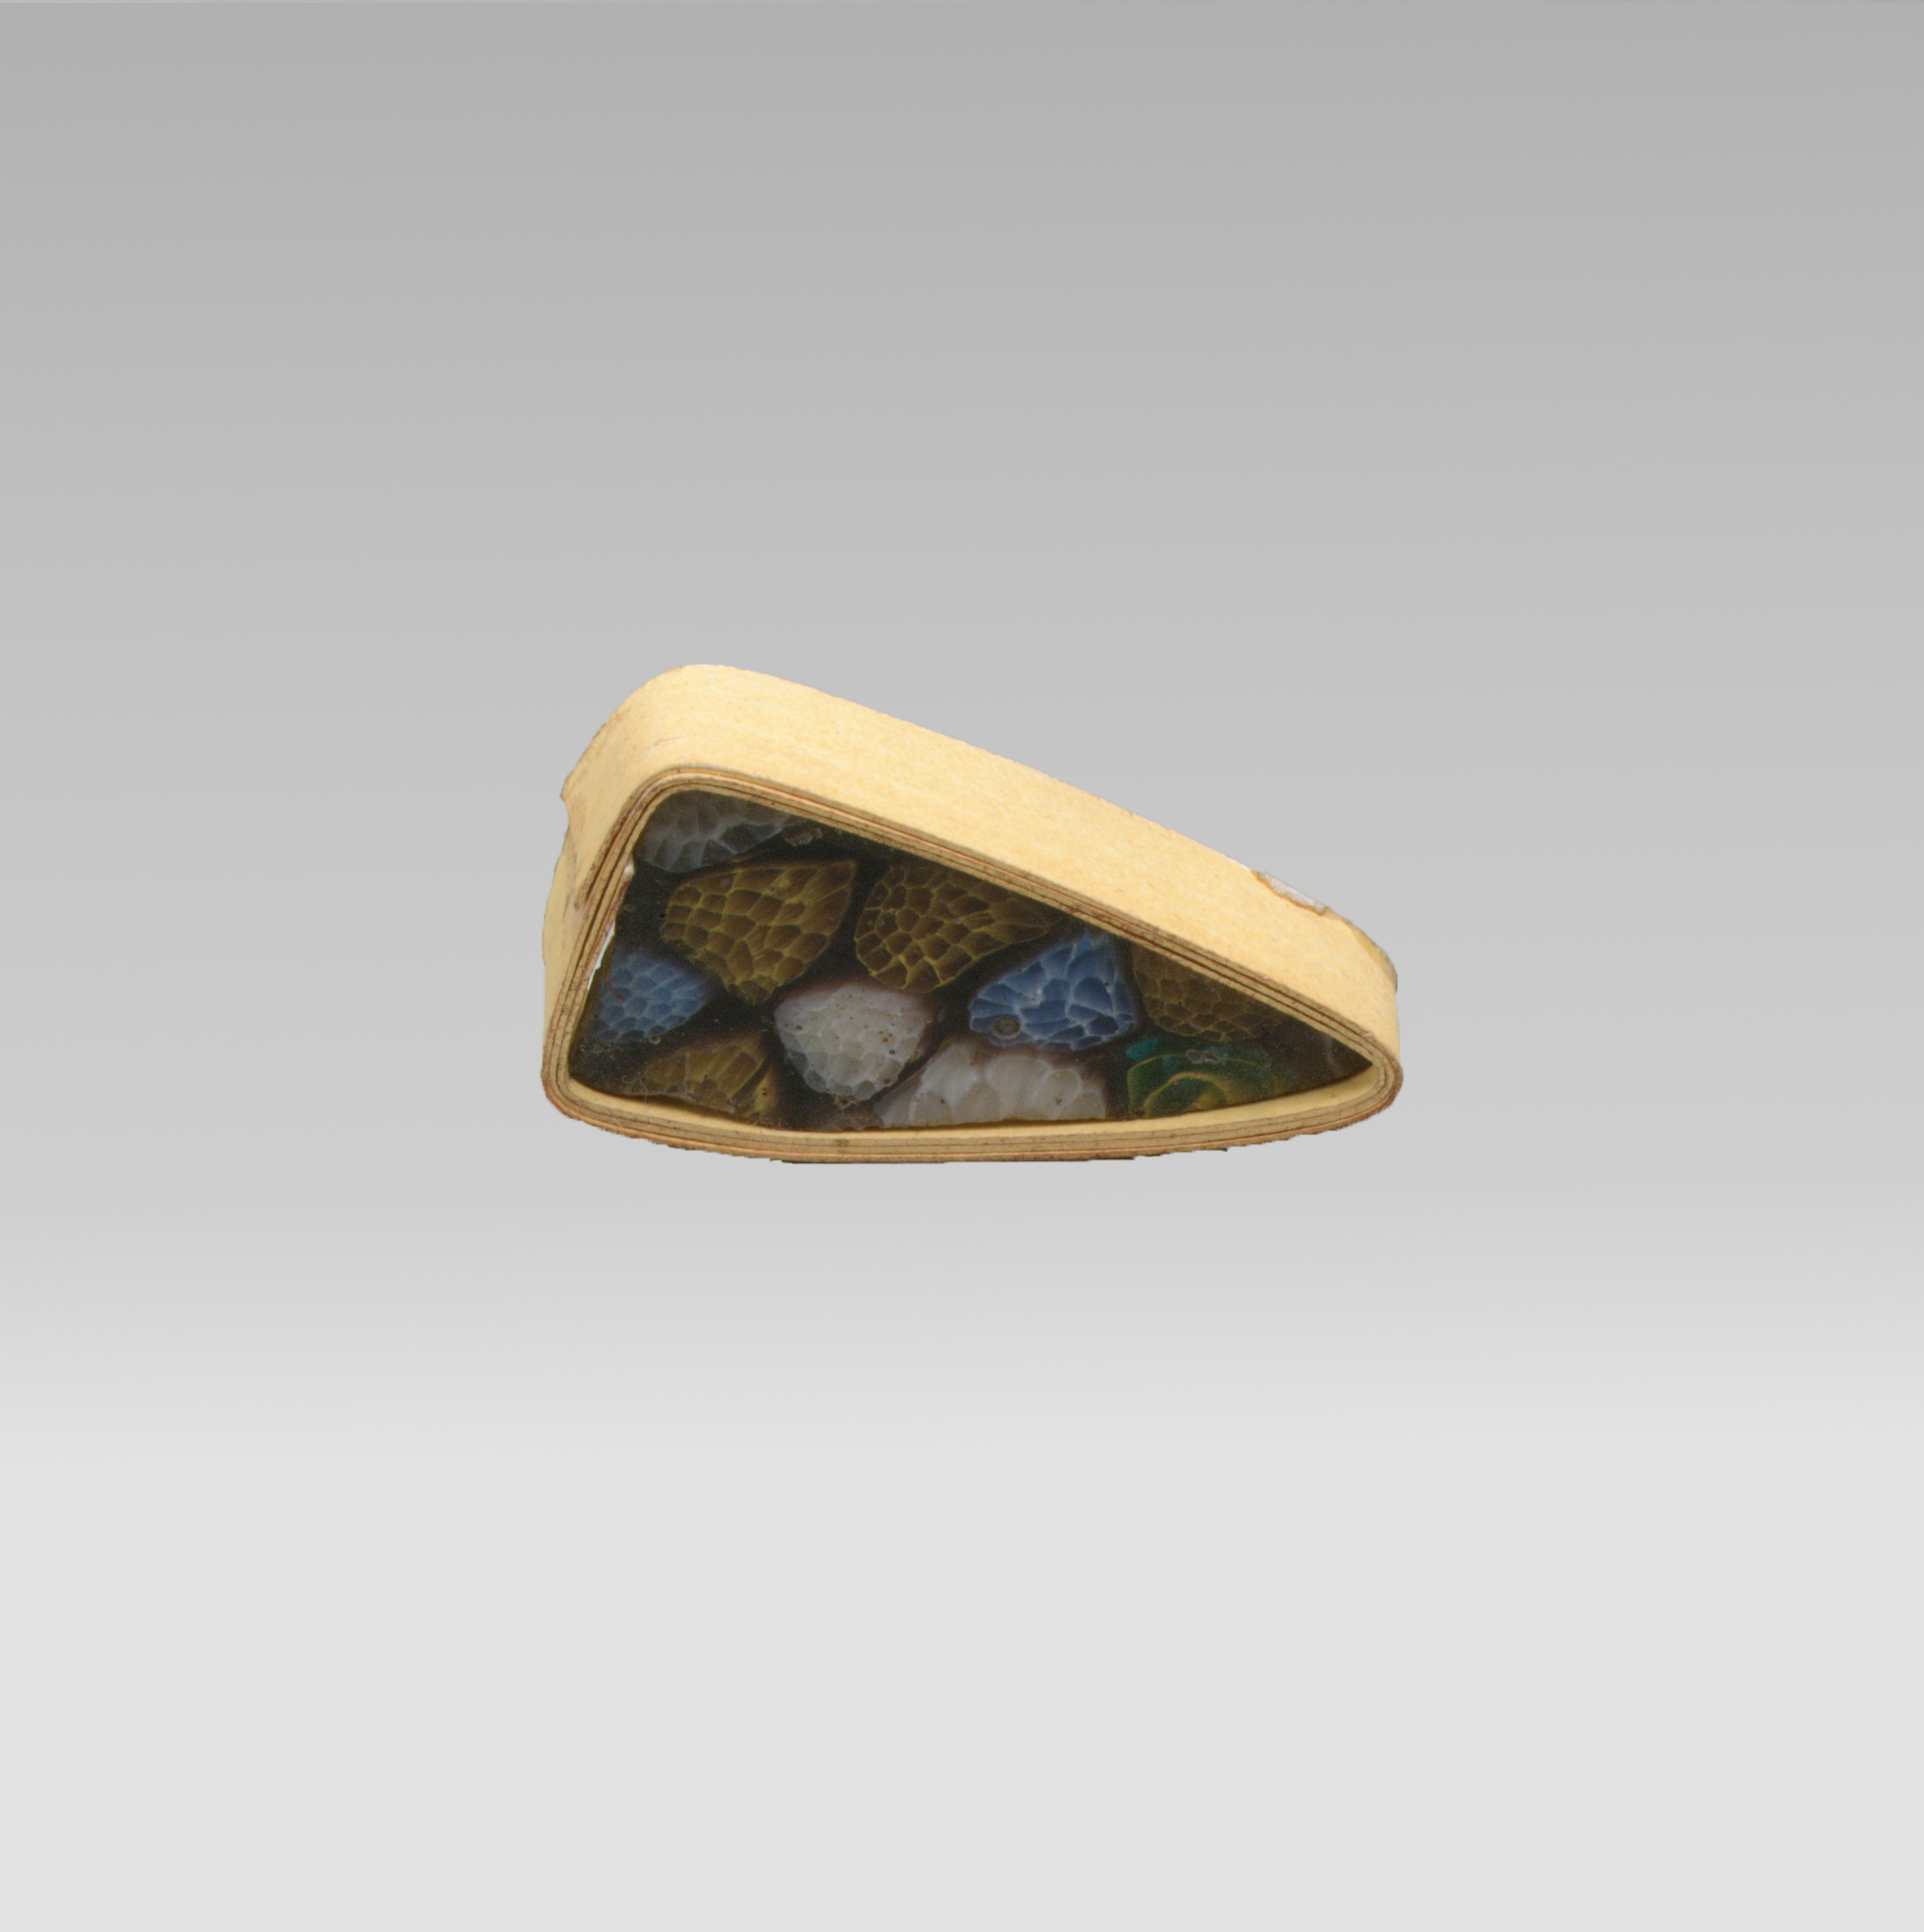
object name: fragment, mosaic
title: Glass mosaic fragment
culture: roman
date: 34 BCE-33 CE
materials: glass